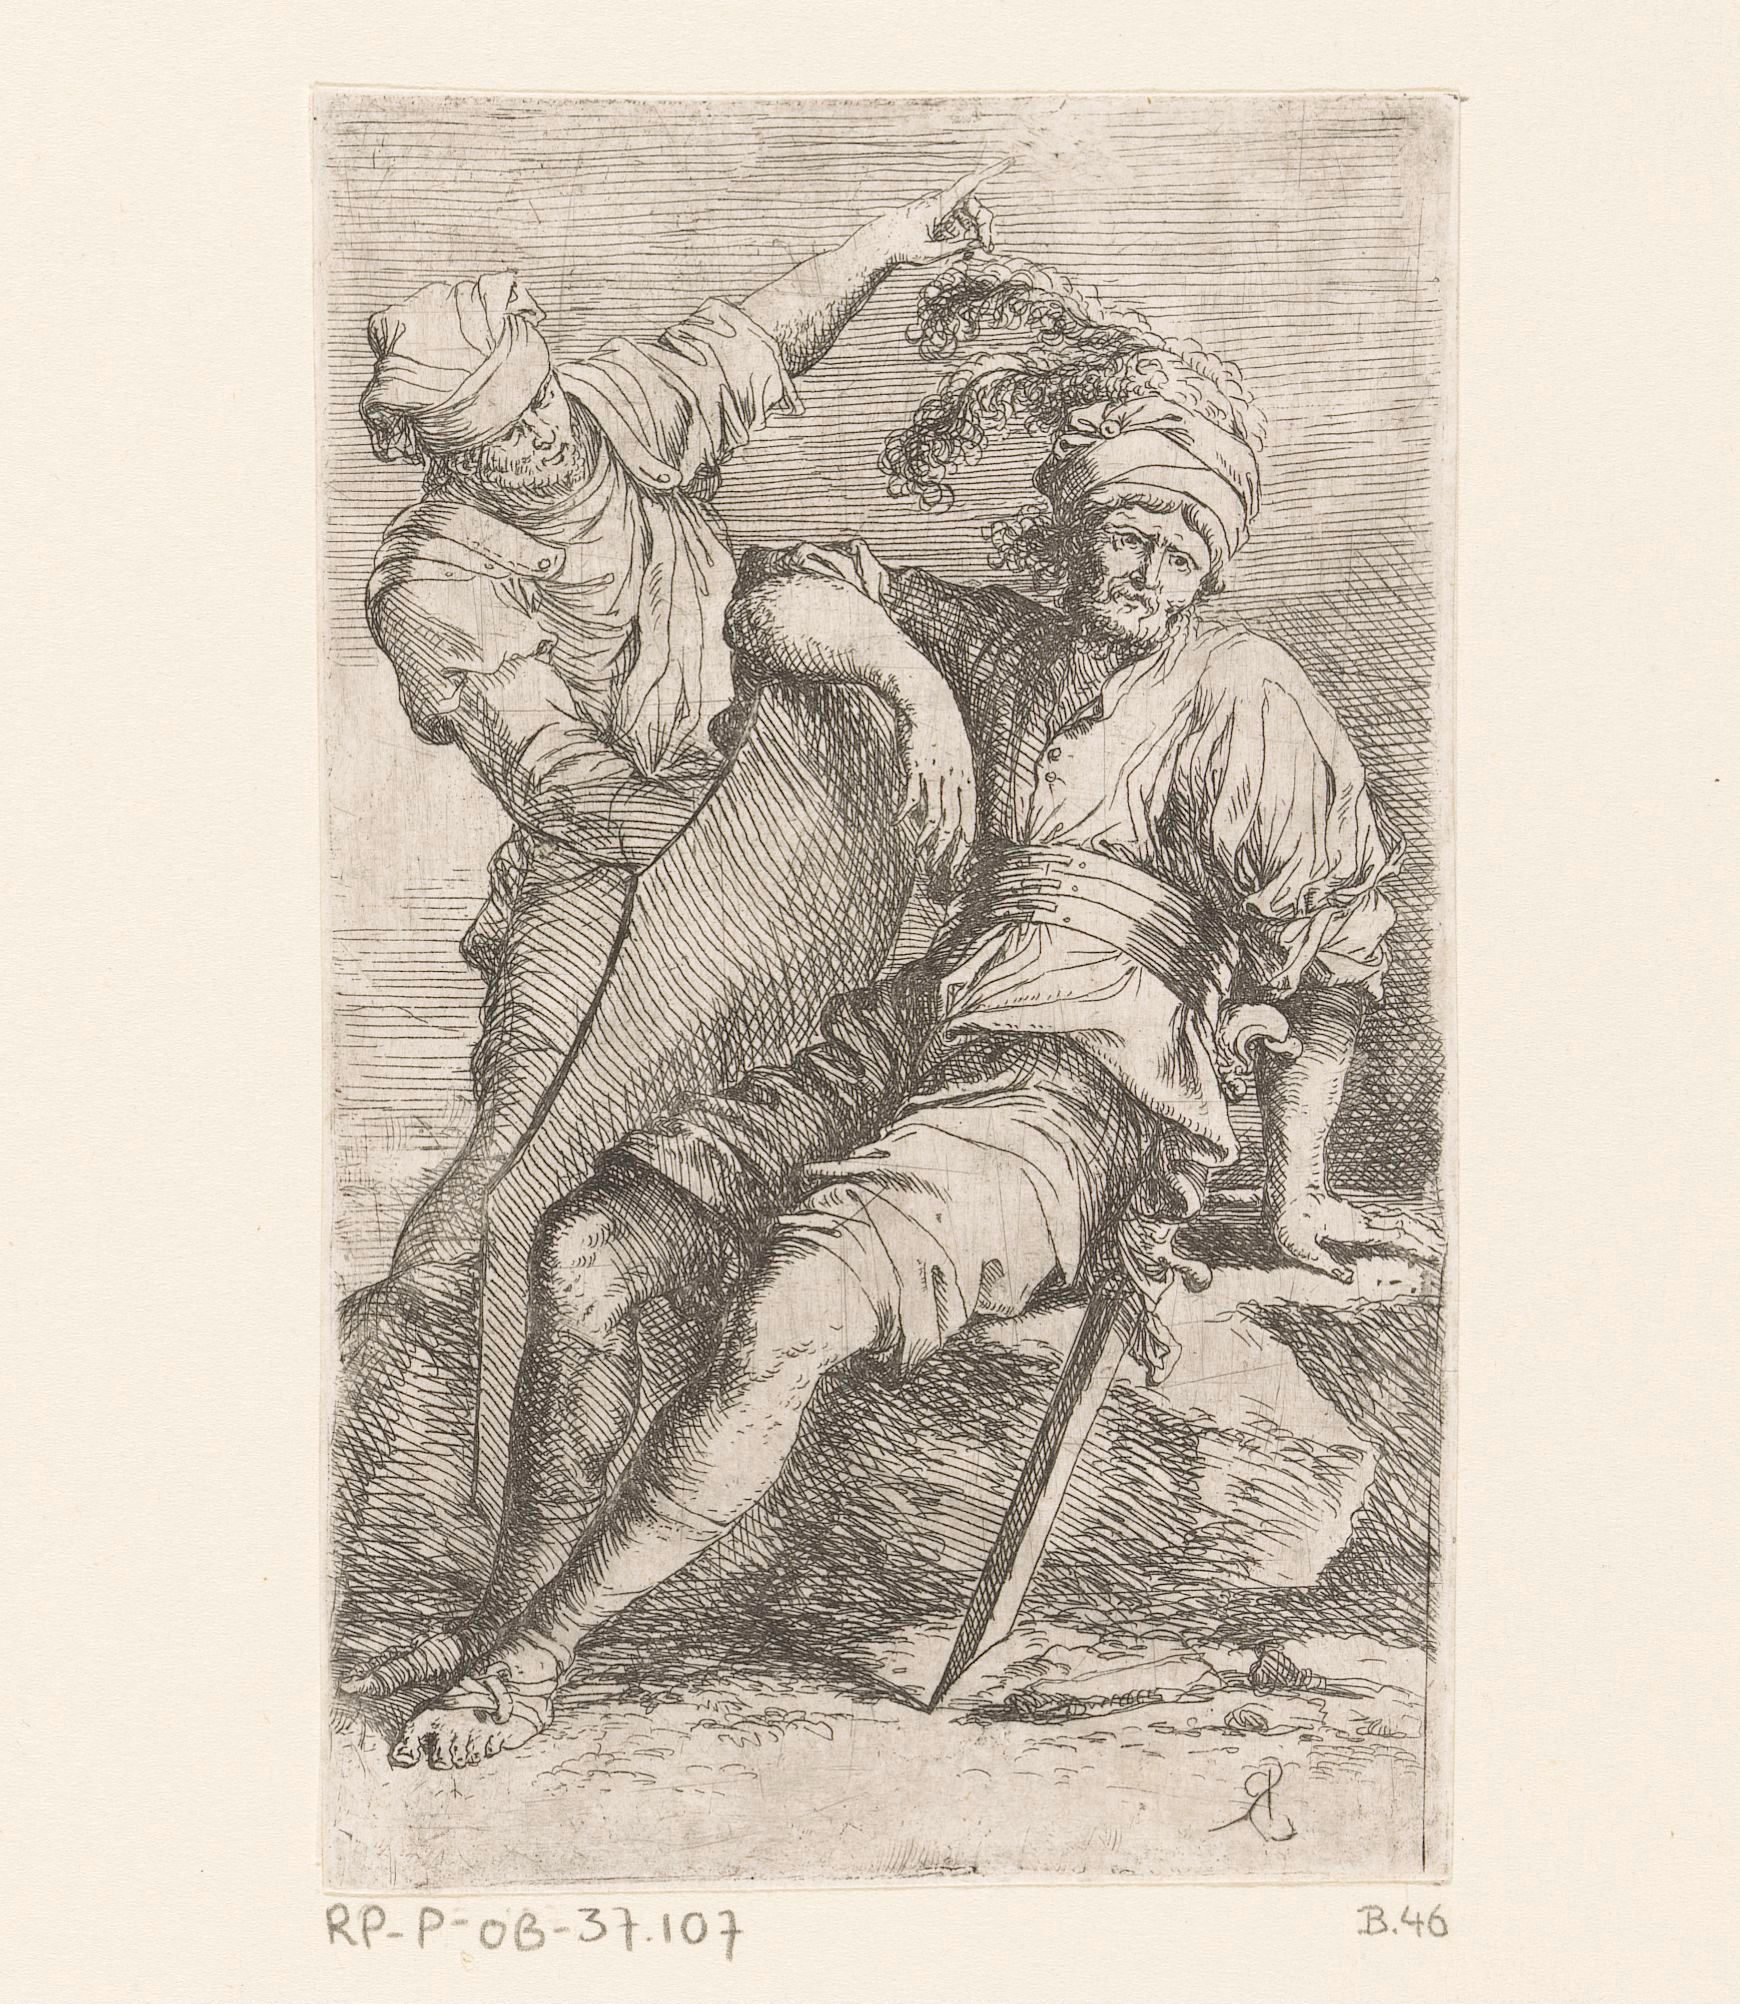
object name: print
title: Kleine figuren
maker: salvator rosa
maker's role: draughtsman, painter, print maker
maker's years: 1615-1673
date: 1656-1657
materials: paper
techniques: drypoint, etching, intaglio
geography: italy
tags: protective weapons: shield, head-gear: turban, the soldier; the soldier's life, index finger forwards, pointing, indicating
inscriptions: collector's mark: Lugt 240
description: Prent spiegelbeeldig naar een tekening die zich eens bevond in de collectie van Ladislao Odescalchi te Rome. De tekening werd in 1974 geveild te Berlijn. Deze prent maakt deel uit van de serie 'Figurine', bestaande uit een titelprent en 80 prenten van klein formaat met voorstellingen van mannelijke en vrouwelijke figuren. Rosa produceerde de serie waarschijnlijk gedurende de jaren 1656 en 1657.